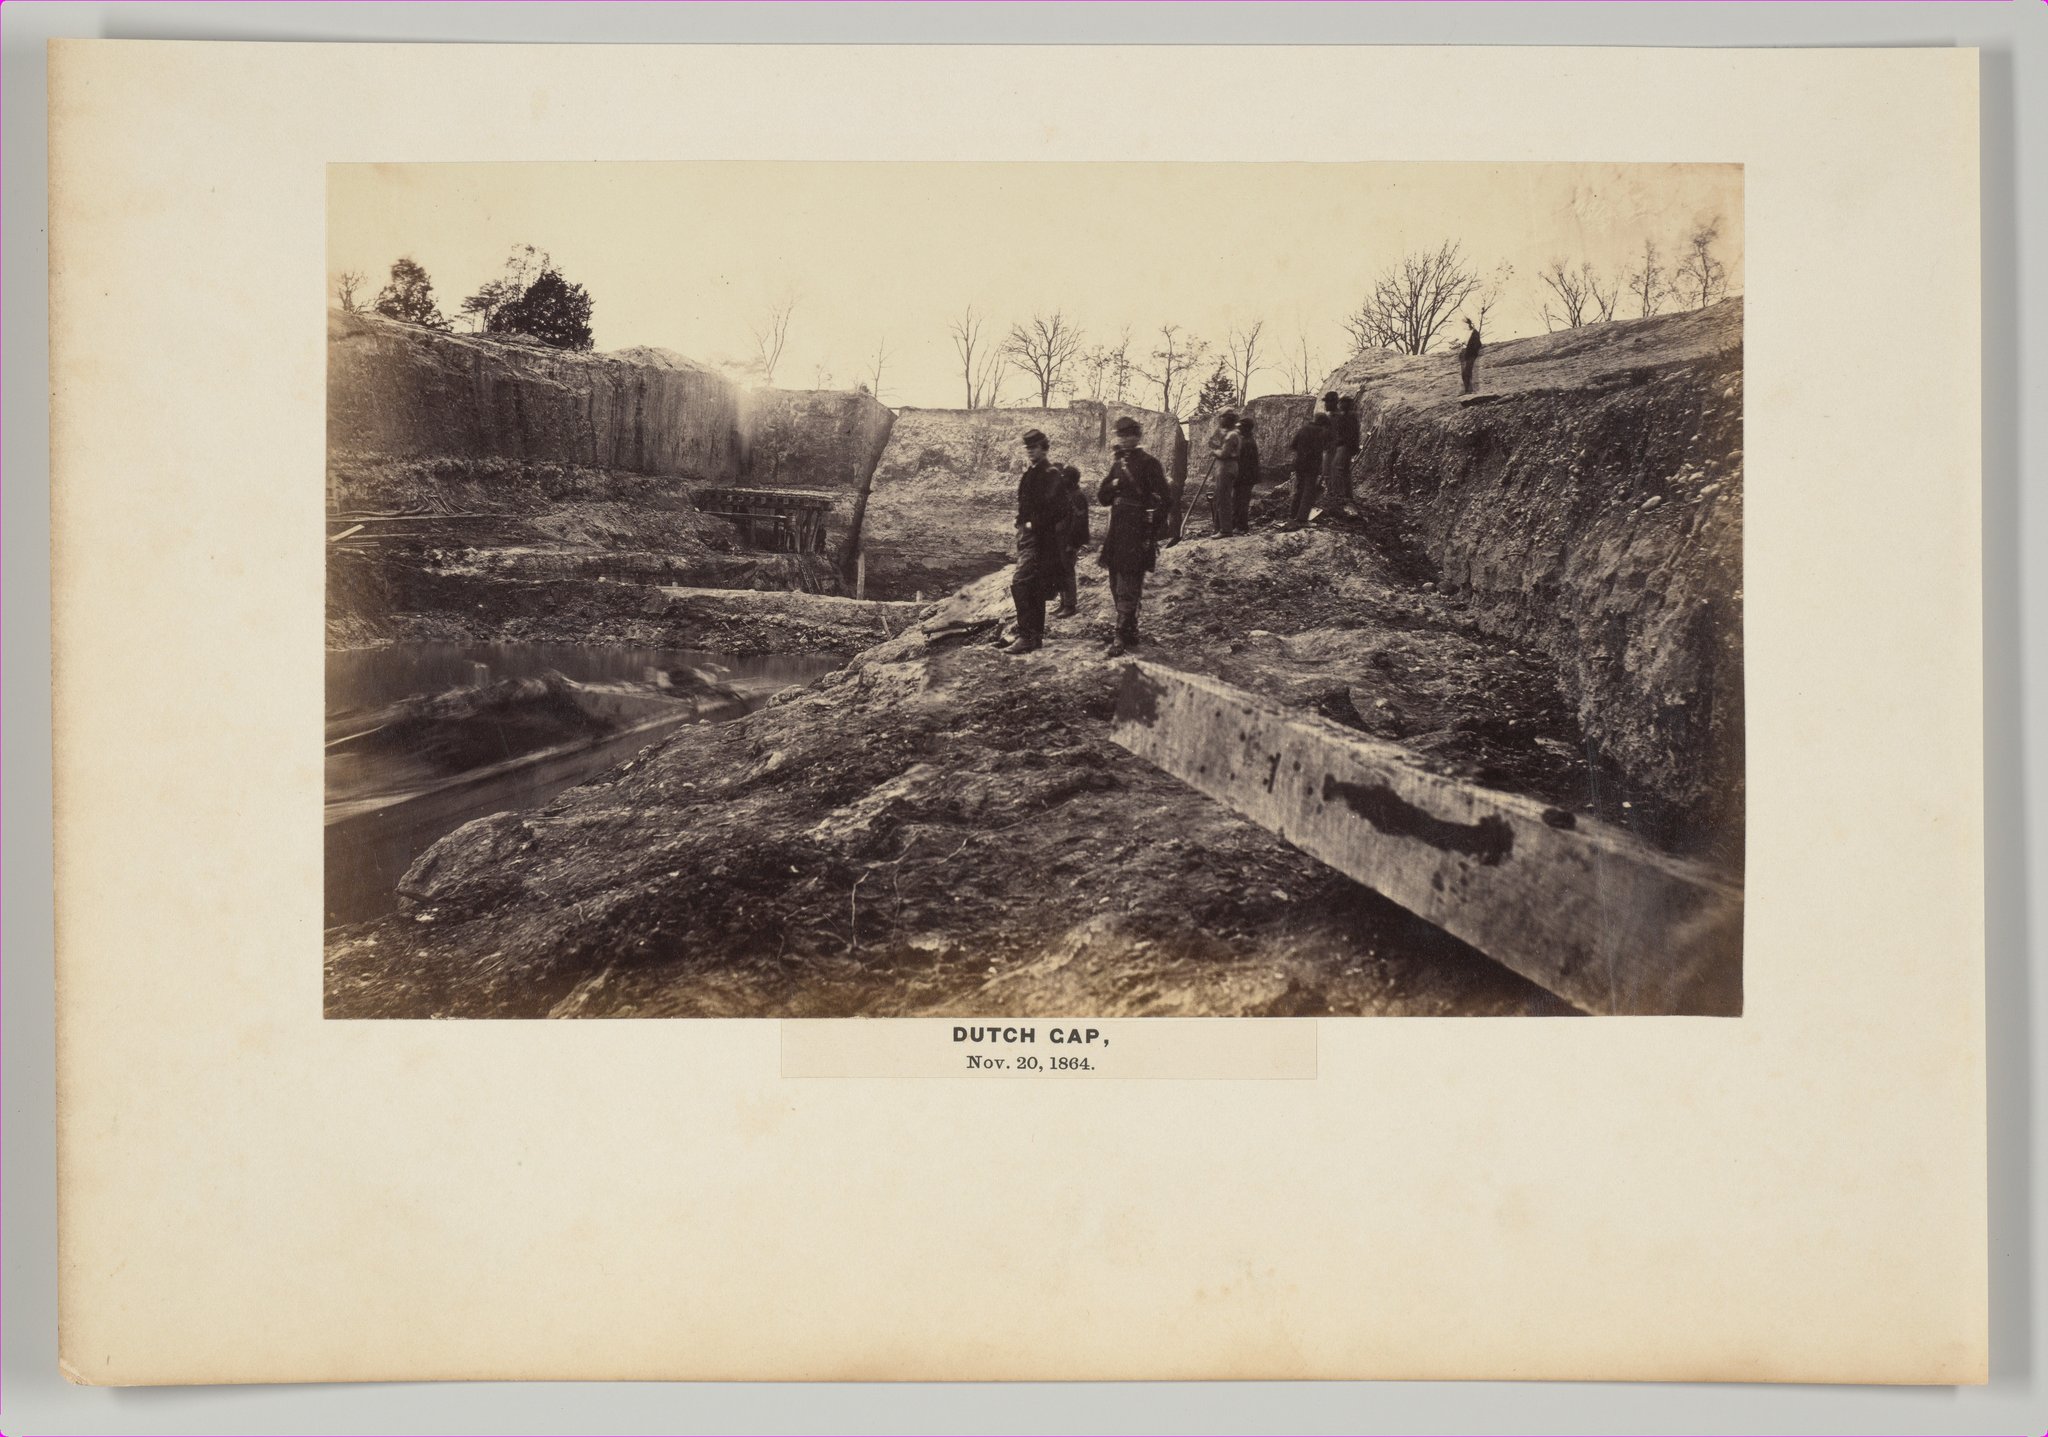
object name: photograph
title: Dutch Gap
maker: andrew joseph russell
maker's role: artist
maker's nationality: american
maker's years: 1830-1902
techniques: albumen silver print, glass negative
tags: american civil war